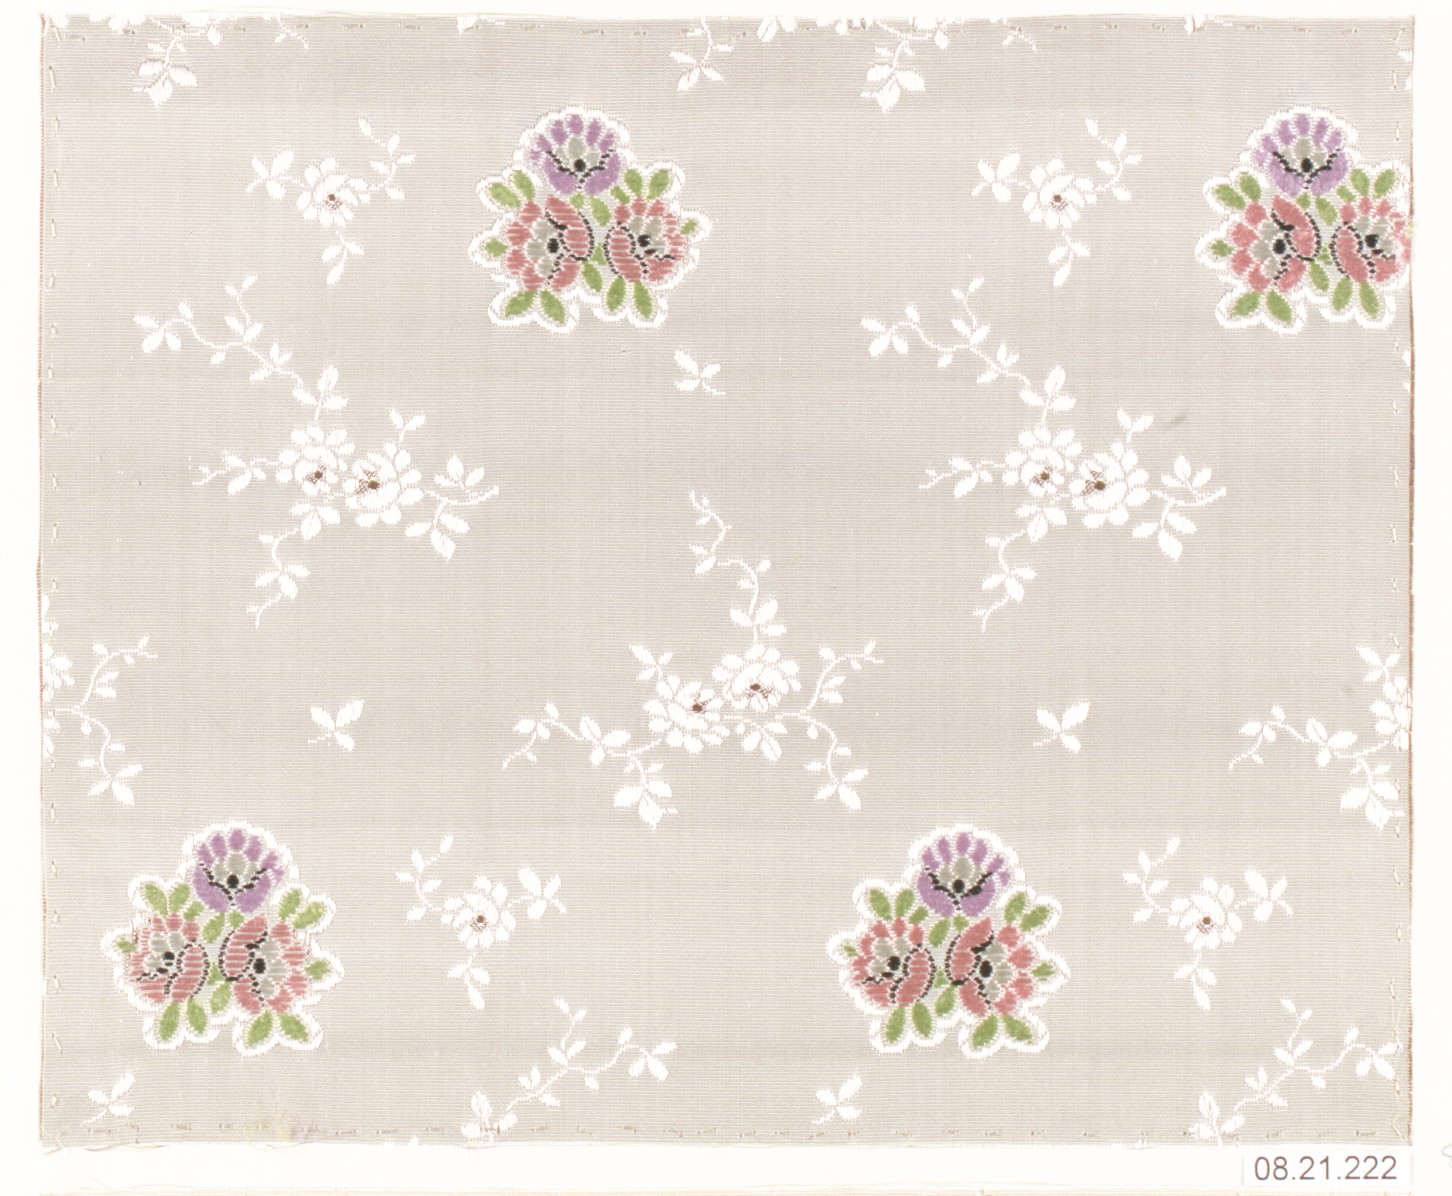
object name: textile sample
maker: Anonymous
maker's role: designer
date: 1900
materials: silk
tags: flowers